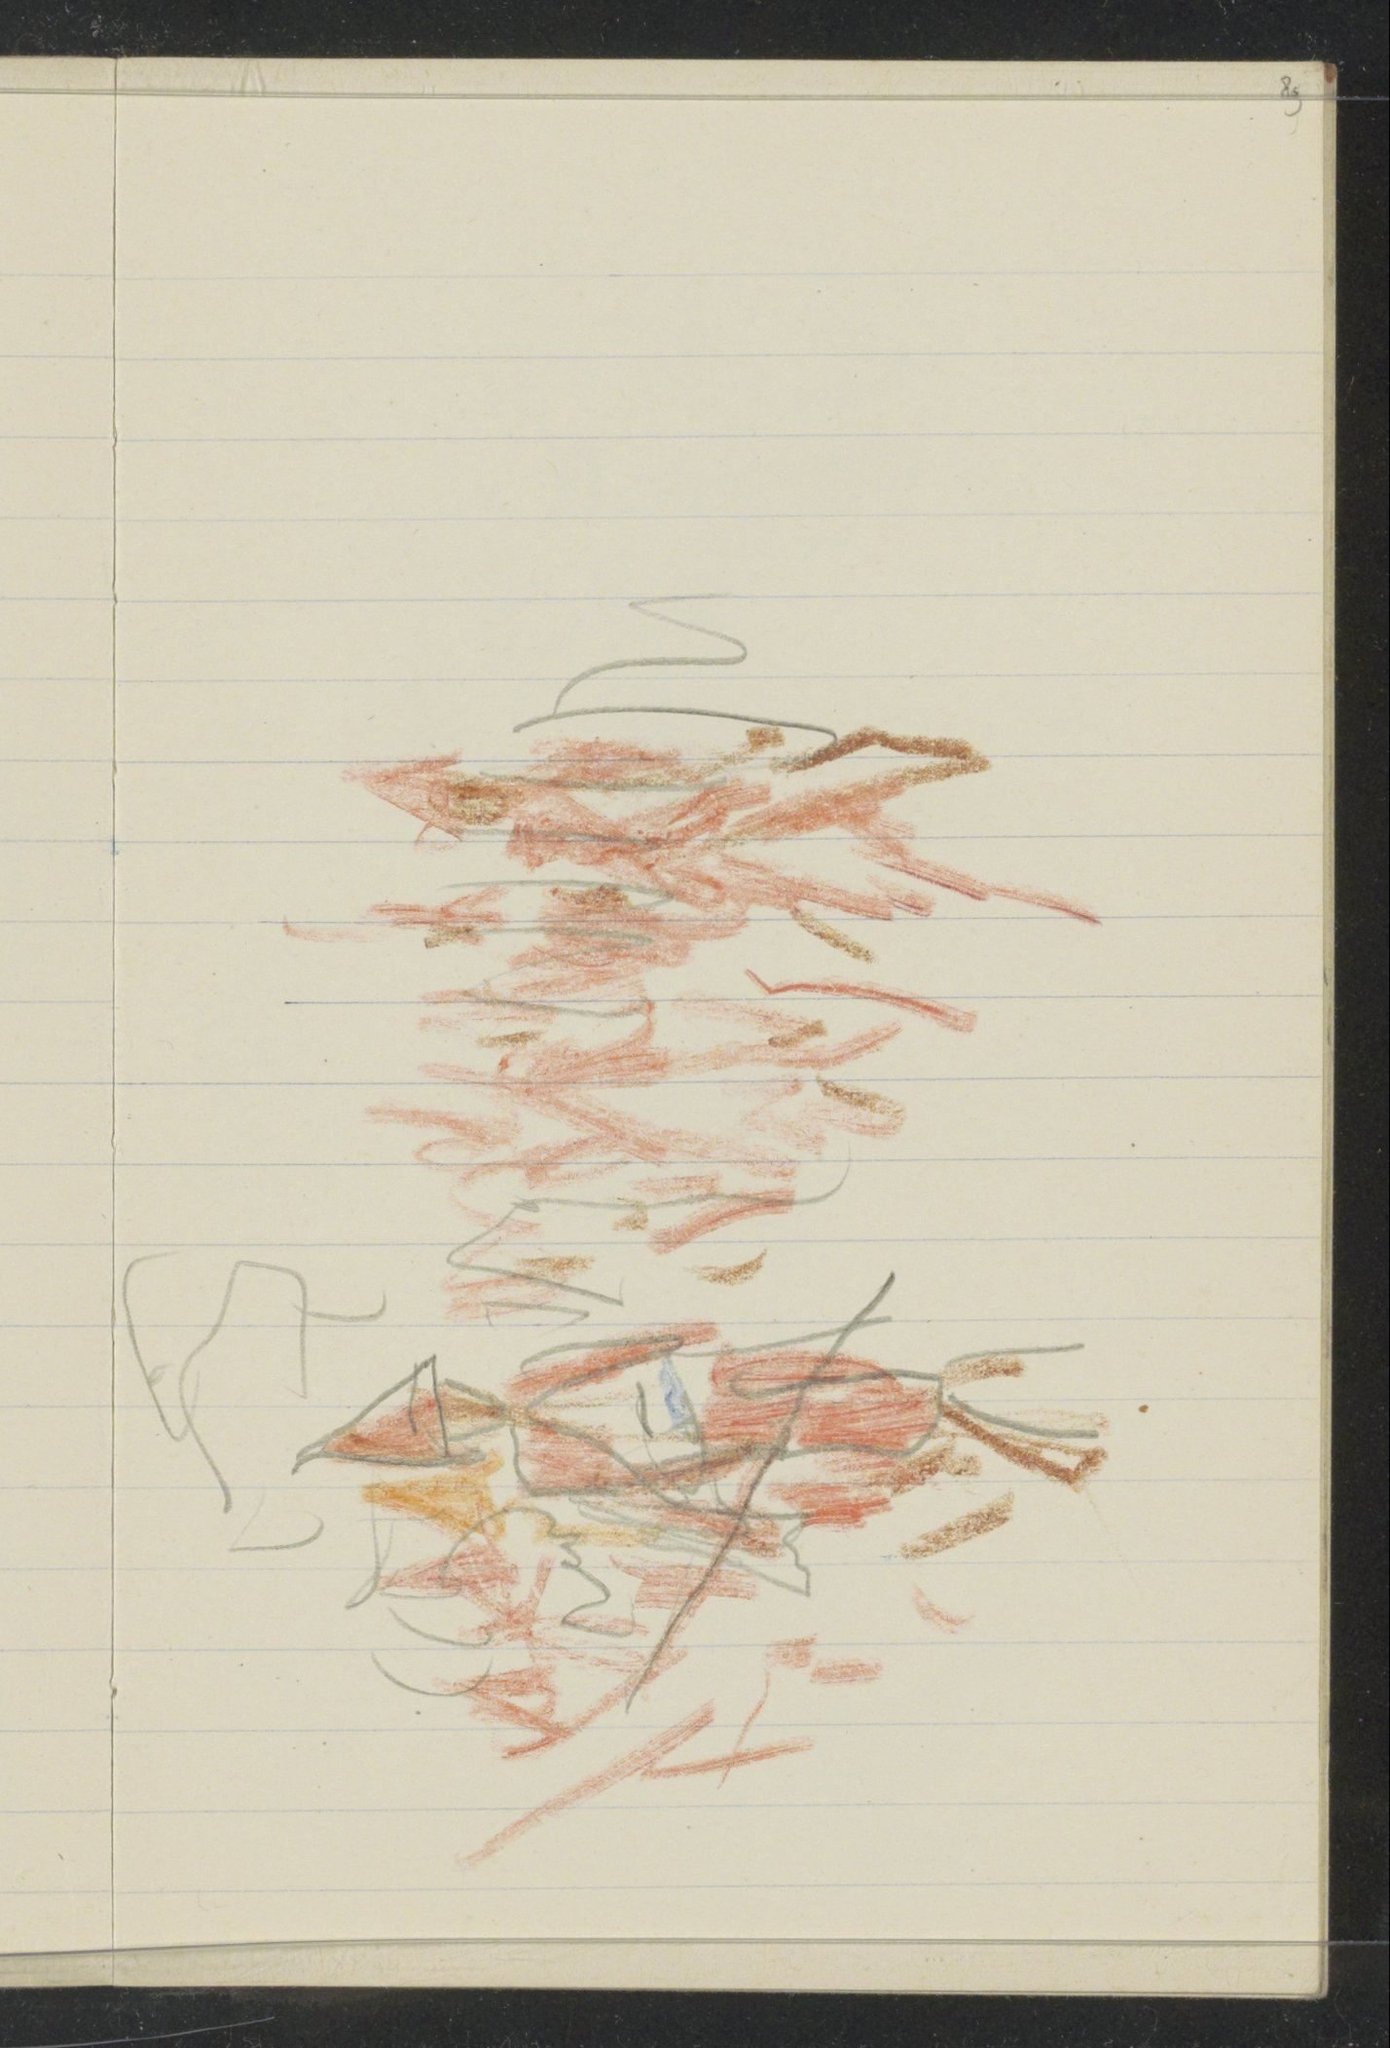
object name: sketchbook leaf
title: Twee lansdragers in uniform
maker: marius bauer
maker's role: draughtsman, print maker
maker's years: 1867-1932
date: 1931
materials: chalk, pencil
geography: java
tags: casting weapons: spear, (military) uniforms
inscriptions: kleurnotitie, handgeschreven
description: Vermoedelijk maken zij deel uit van een optocht. Pagina 89 uit een schetsboek met 74 bladen.